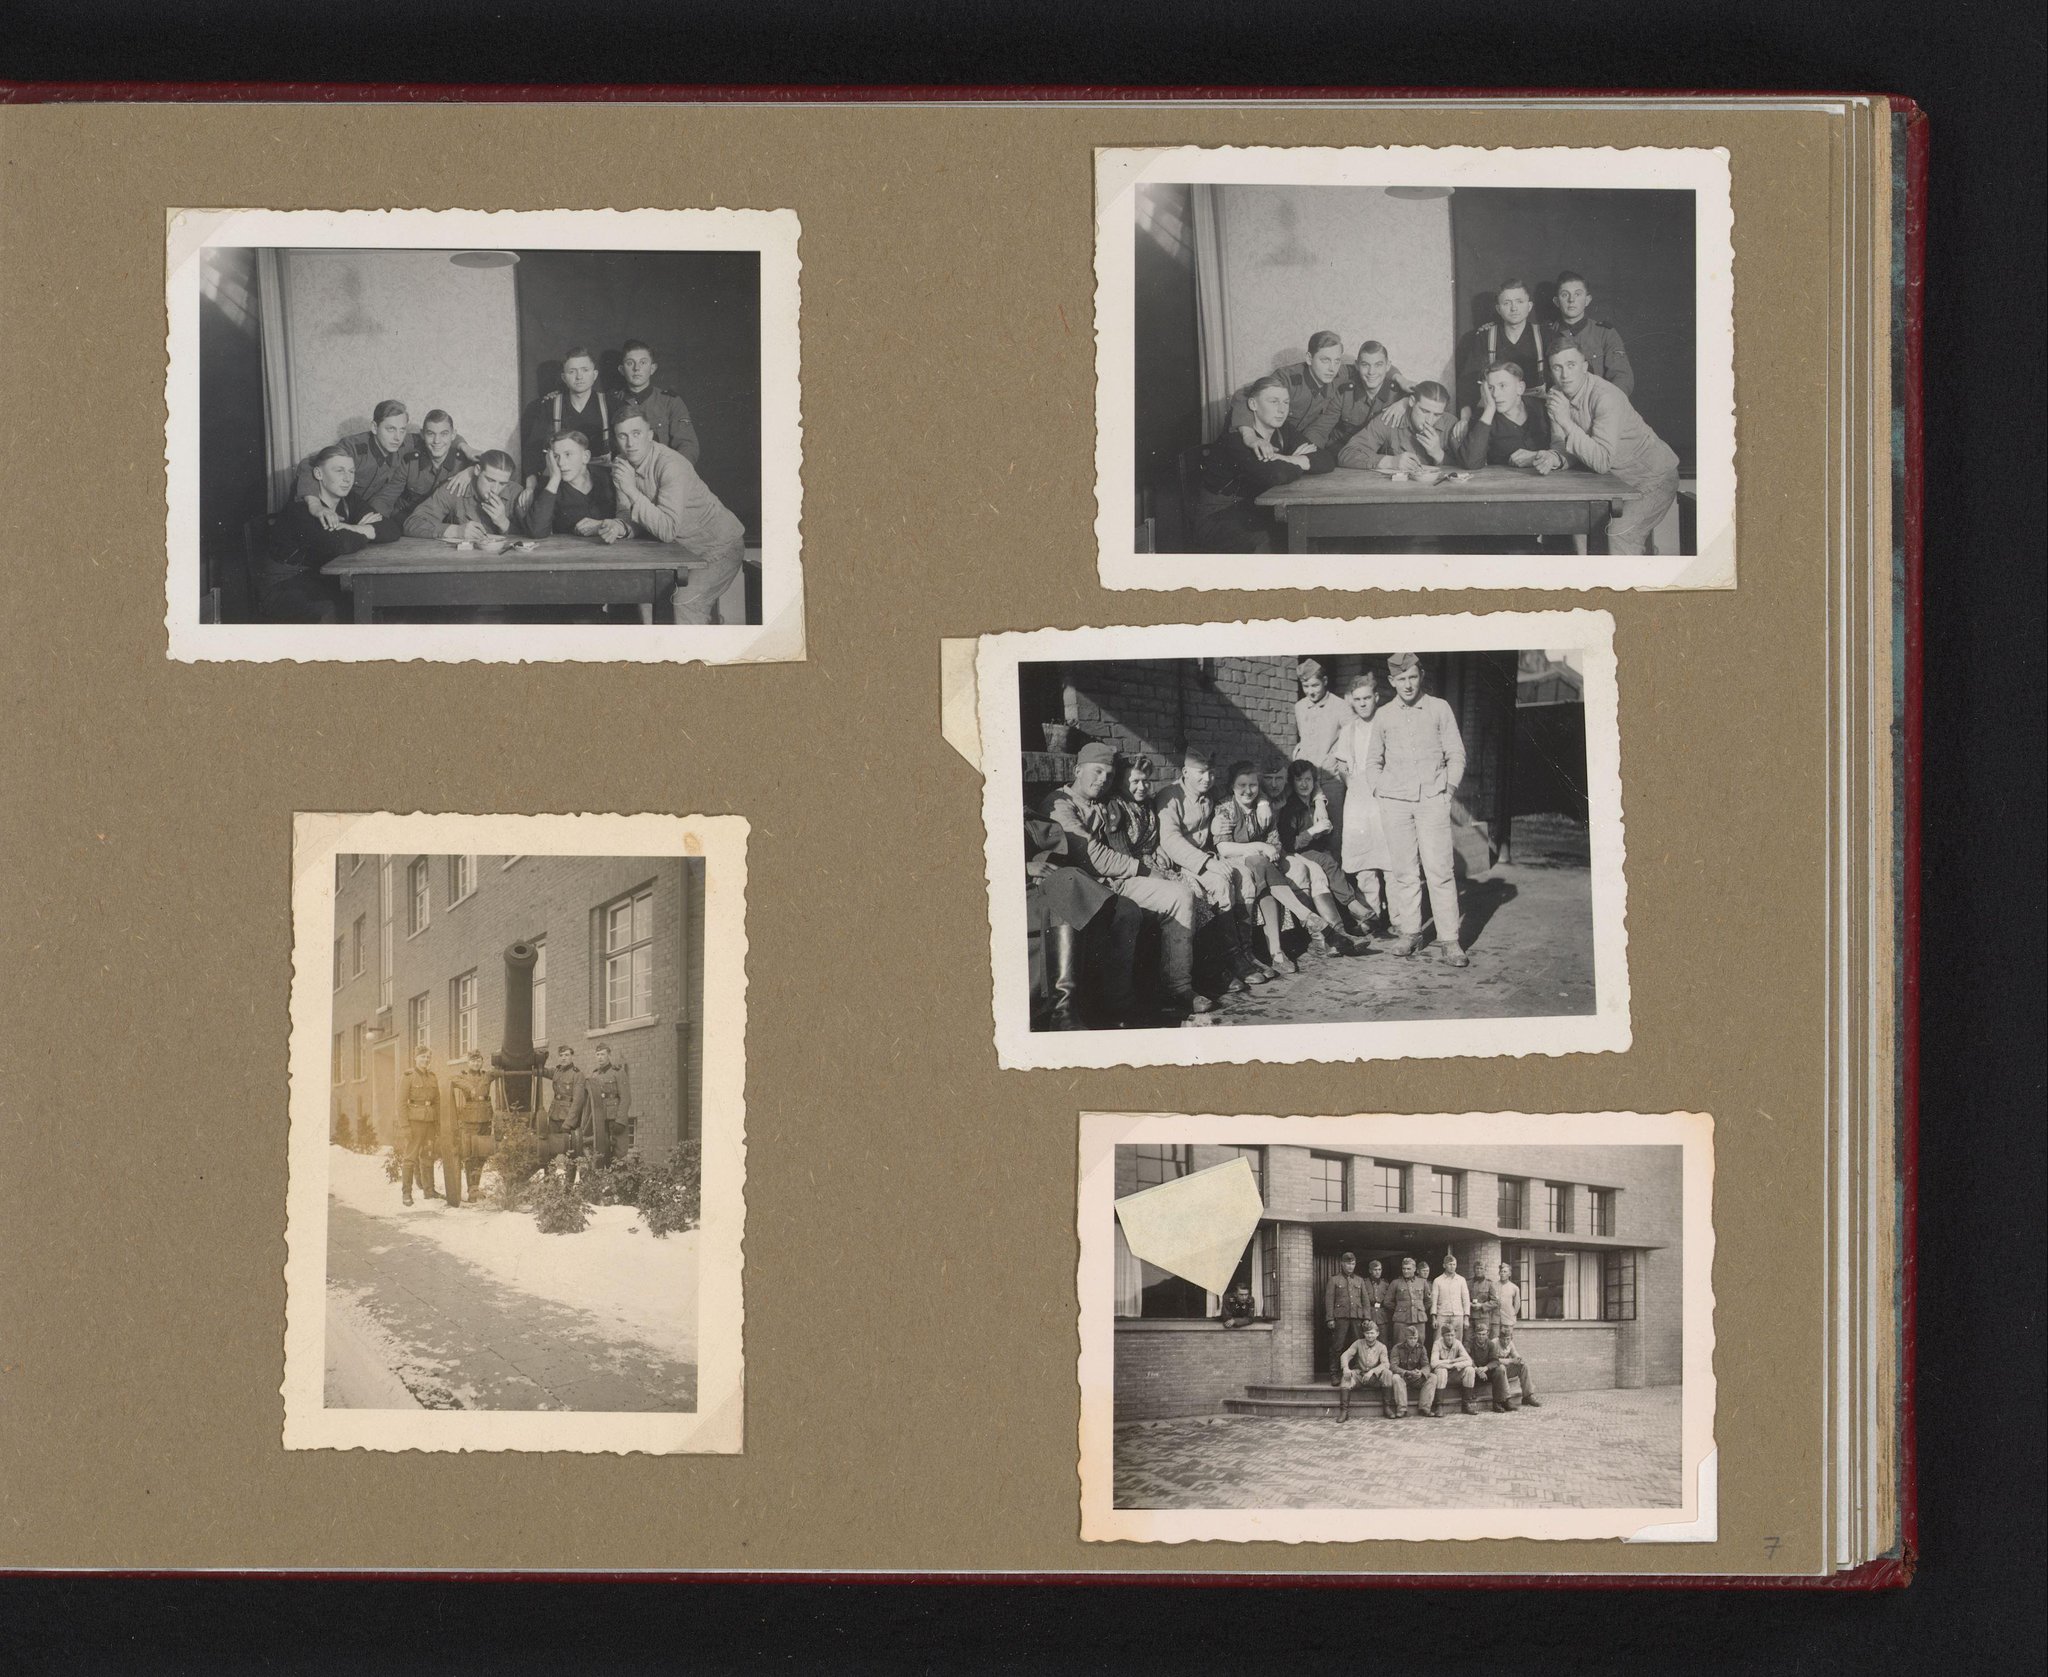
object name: photograph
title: Groepsfoto's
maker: Anonymous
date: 1939-1943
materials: paper, photographic support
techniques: gelatin silver print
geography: germany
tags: the company, the unit, the troop ~ military service, military training, germany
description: Albumblad met vijf foto's van groepen soldaten tijdens de opleiding, vrije tijd en met meisjes. Onderdeel van het fotoalbum over soldaten van de Wehrmacht, ca. 1939-1943.